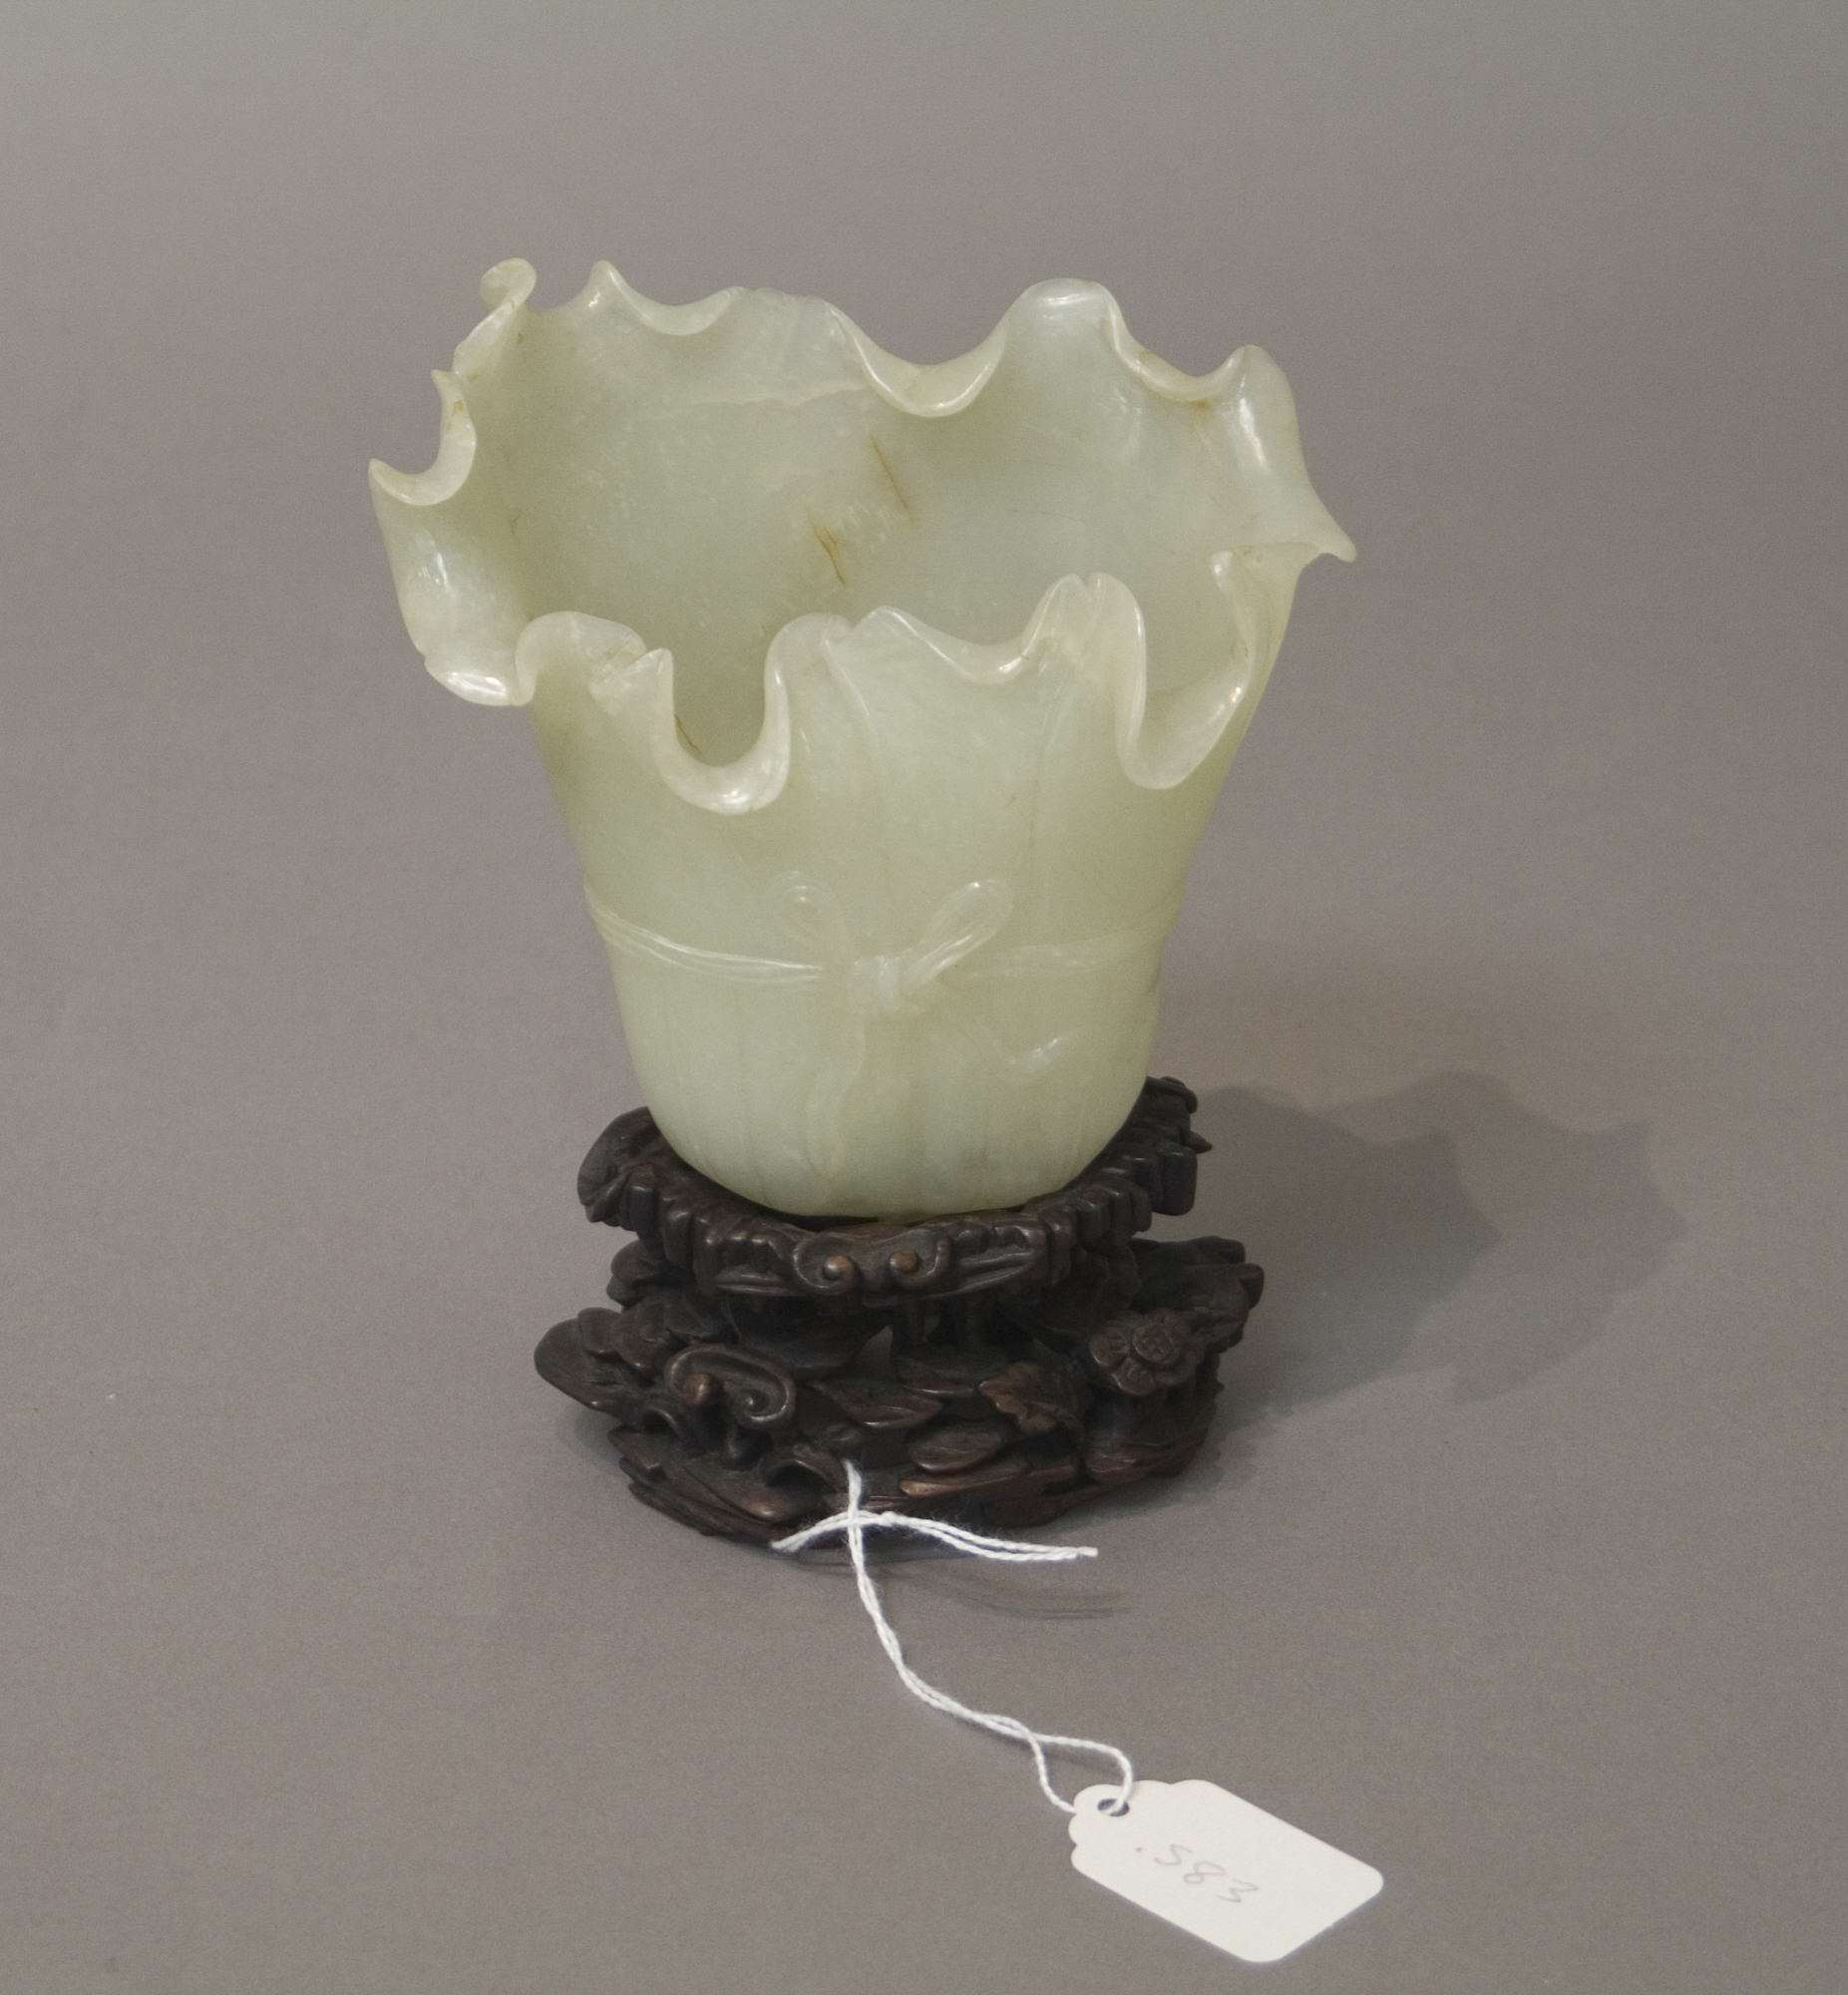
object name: flower vase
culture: chinese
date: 1736-1795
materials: jade